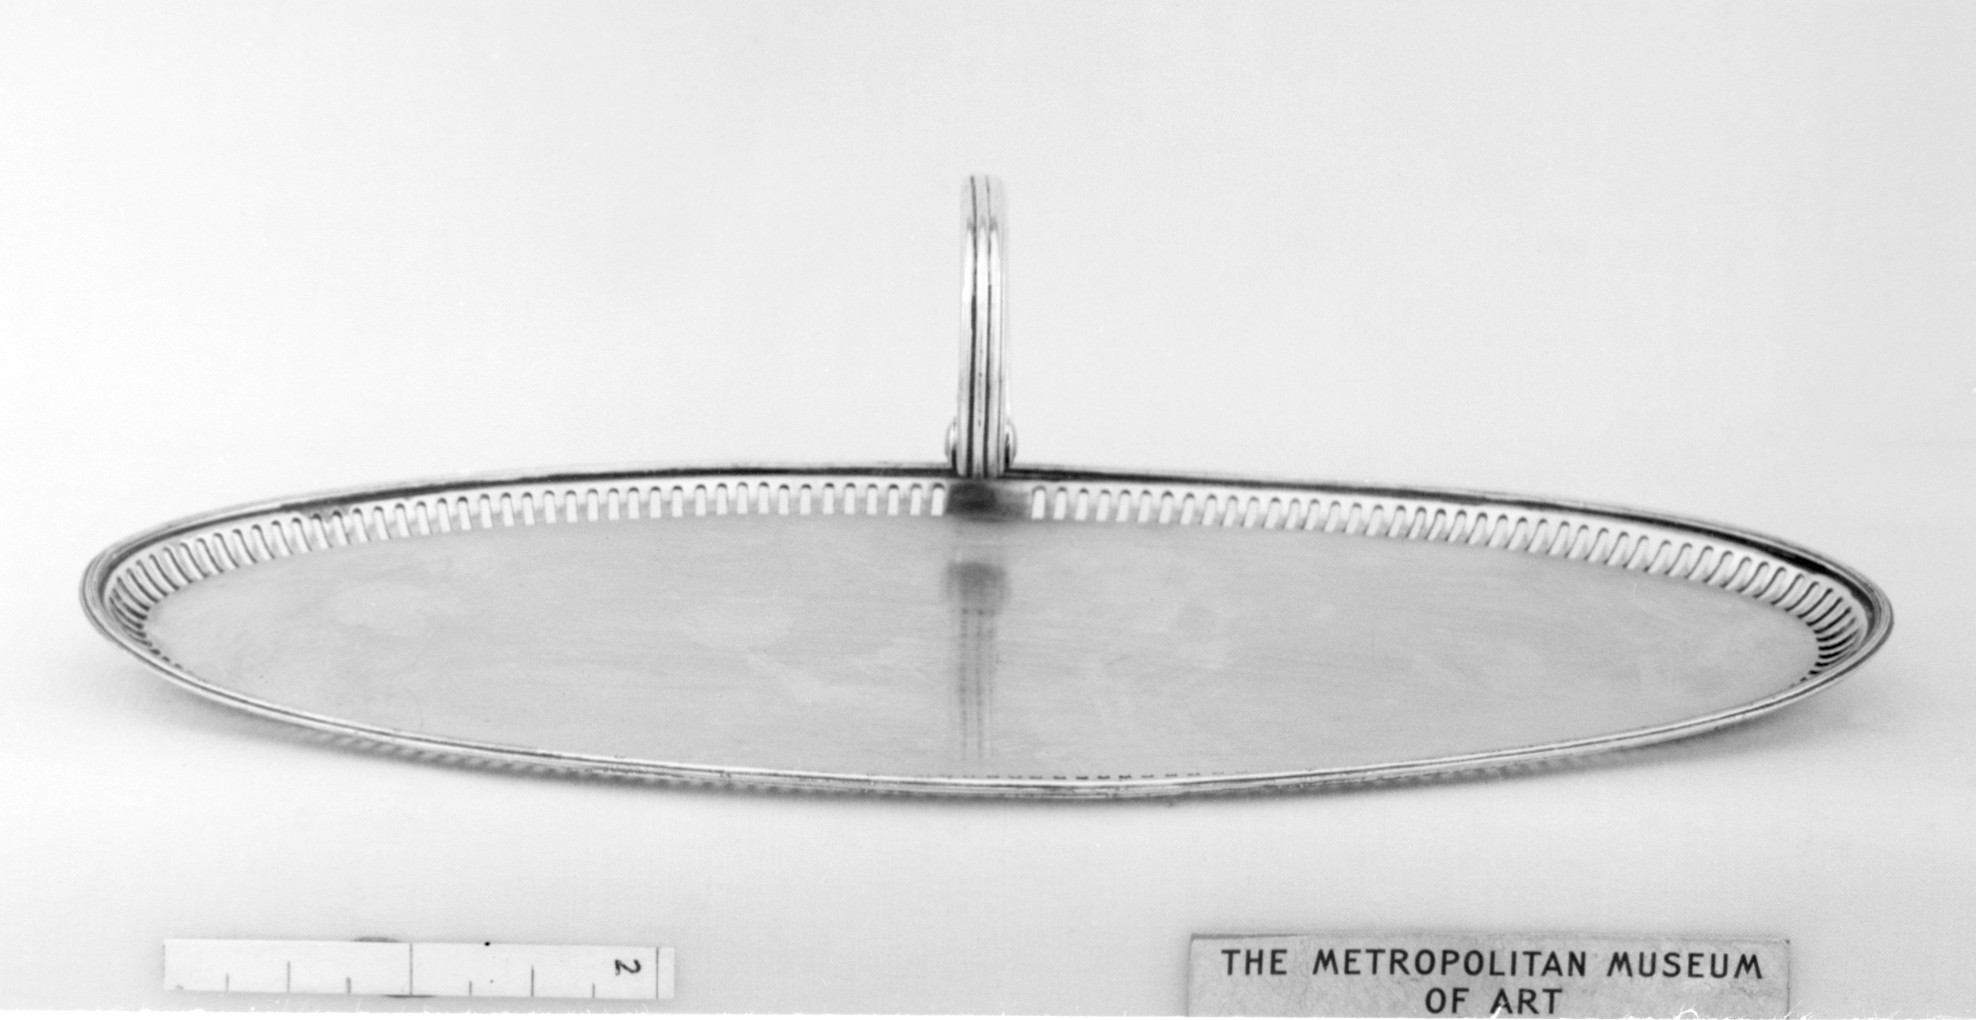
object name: pen tray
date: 1780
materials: metal